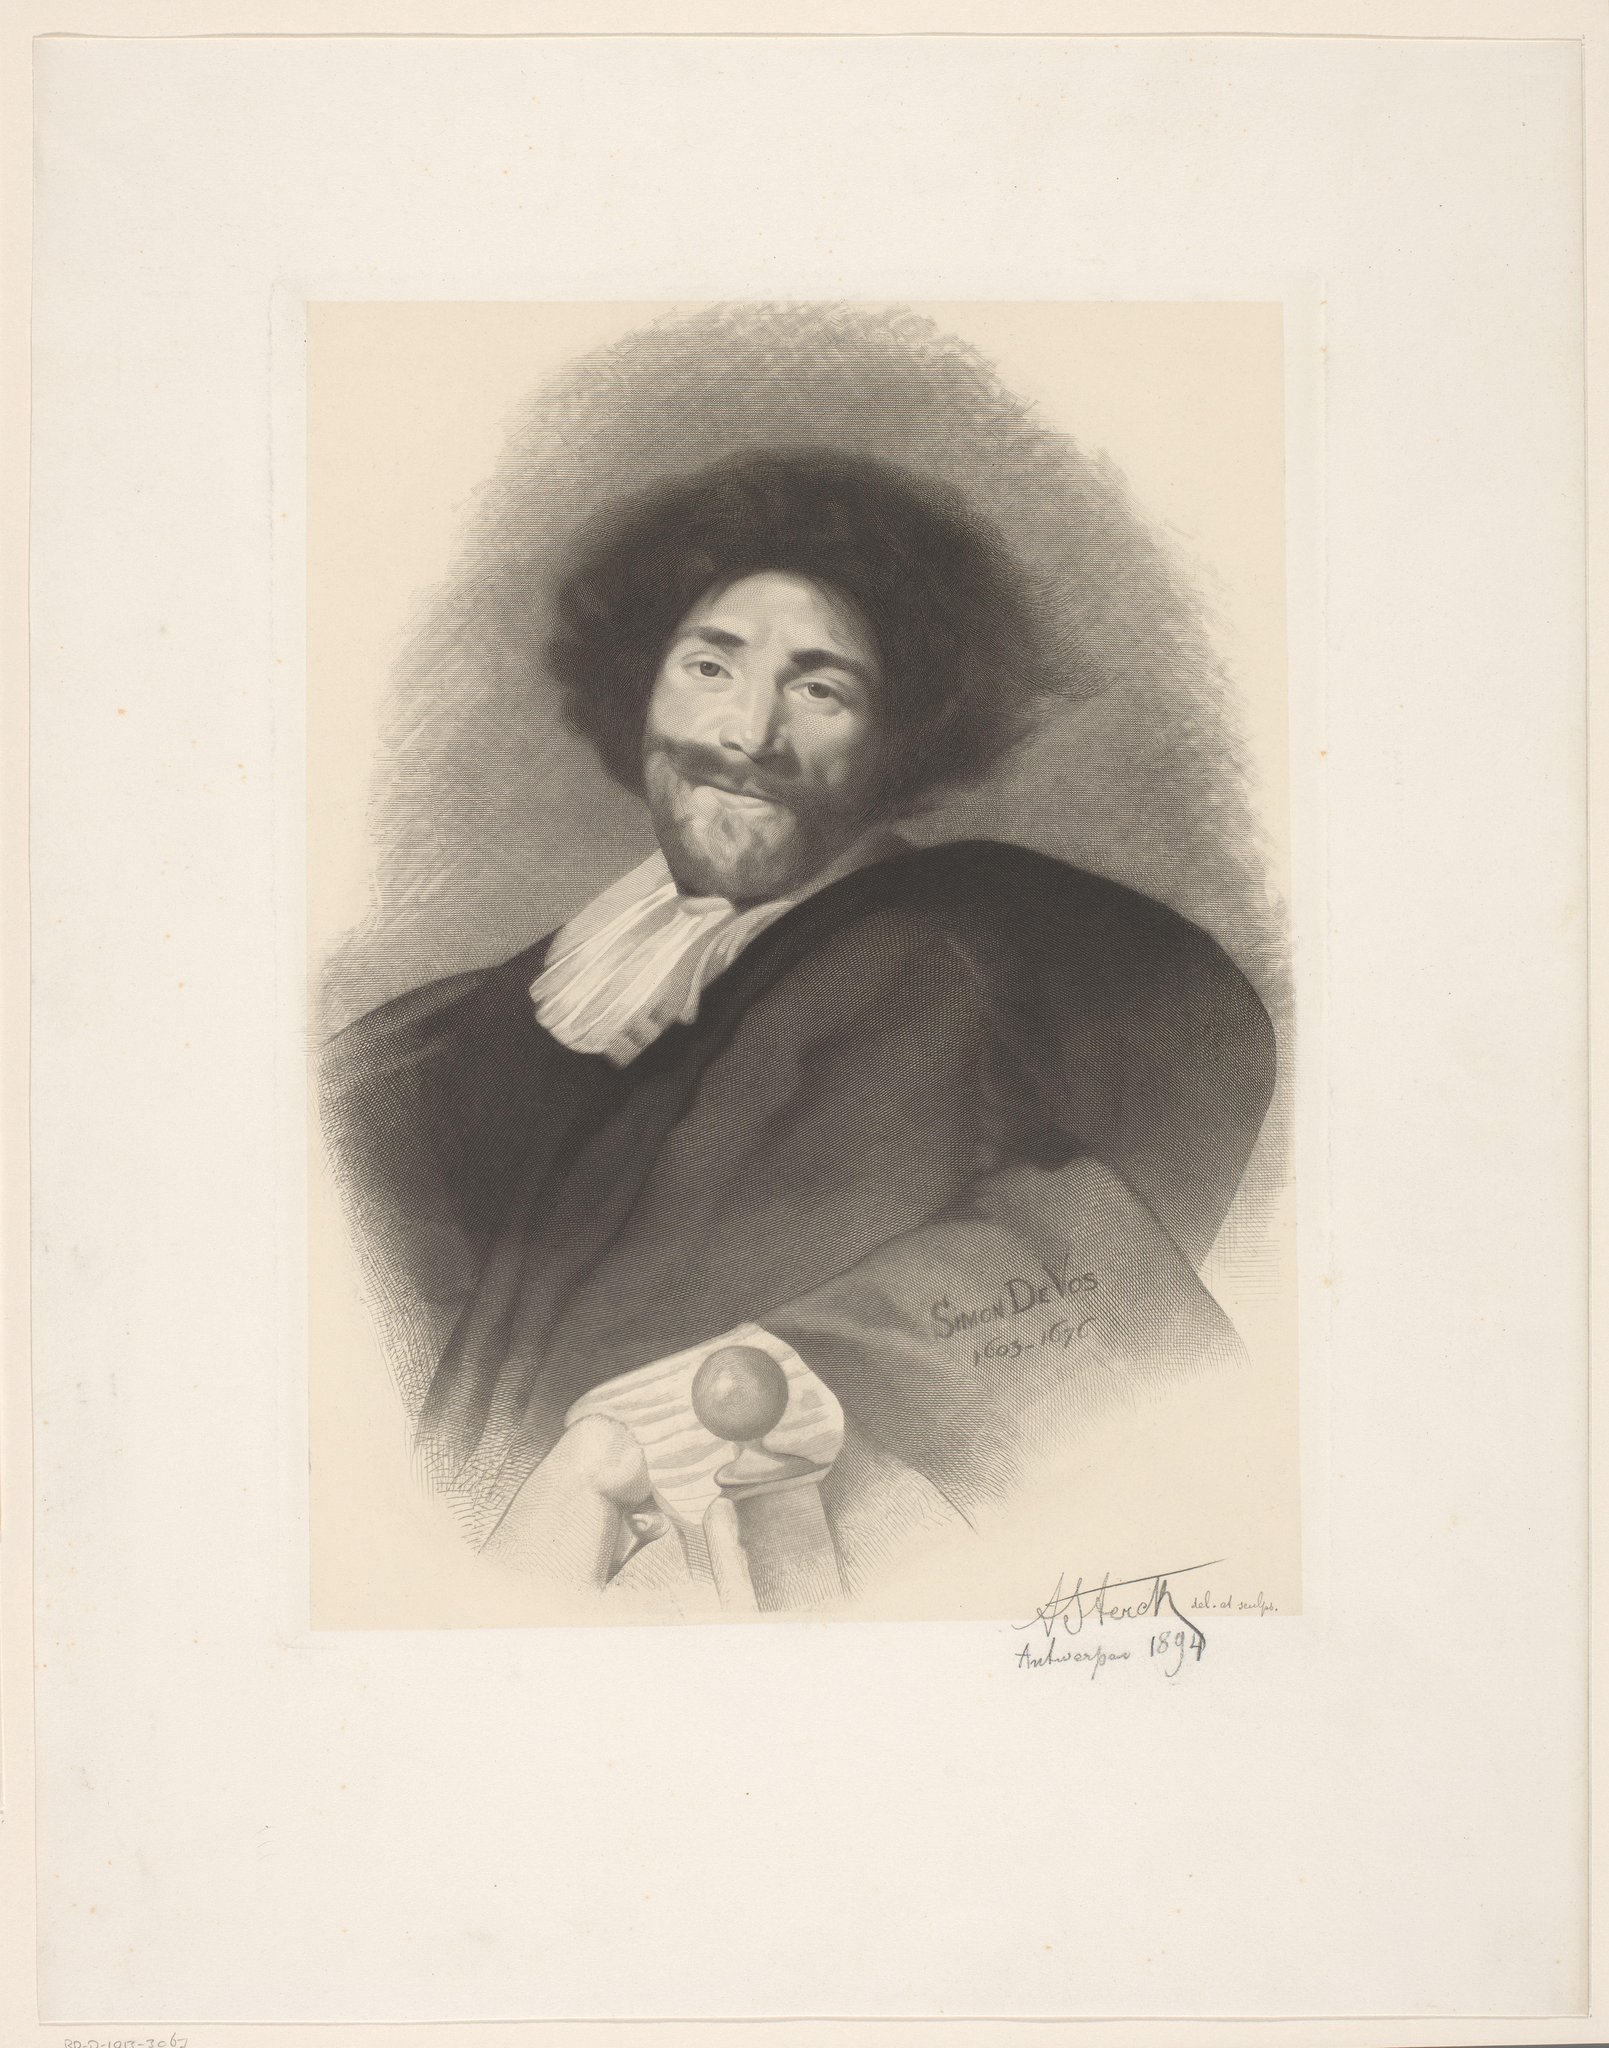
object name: print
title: Simon de Vos 1603-1676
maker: arthur sterck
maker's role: print maker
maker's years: 1868-1897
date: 1894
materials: paper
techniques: engraving, etching, roulette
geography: antwerp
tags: antwerp, painter, historical persons, portrait, self-portrait of painter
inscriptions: collector's mark: Lugt 2228